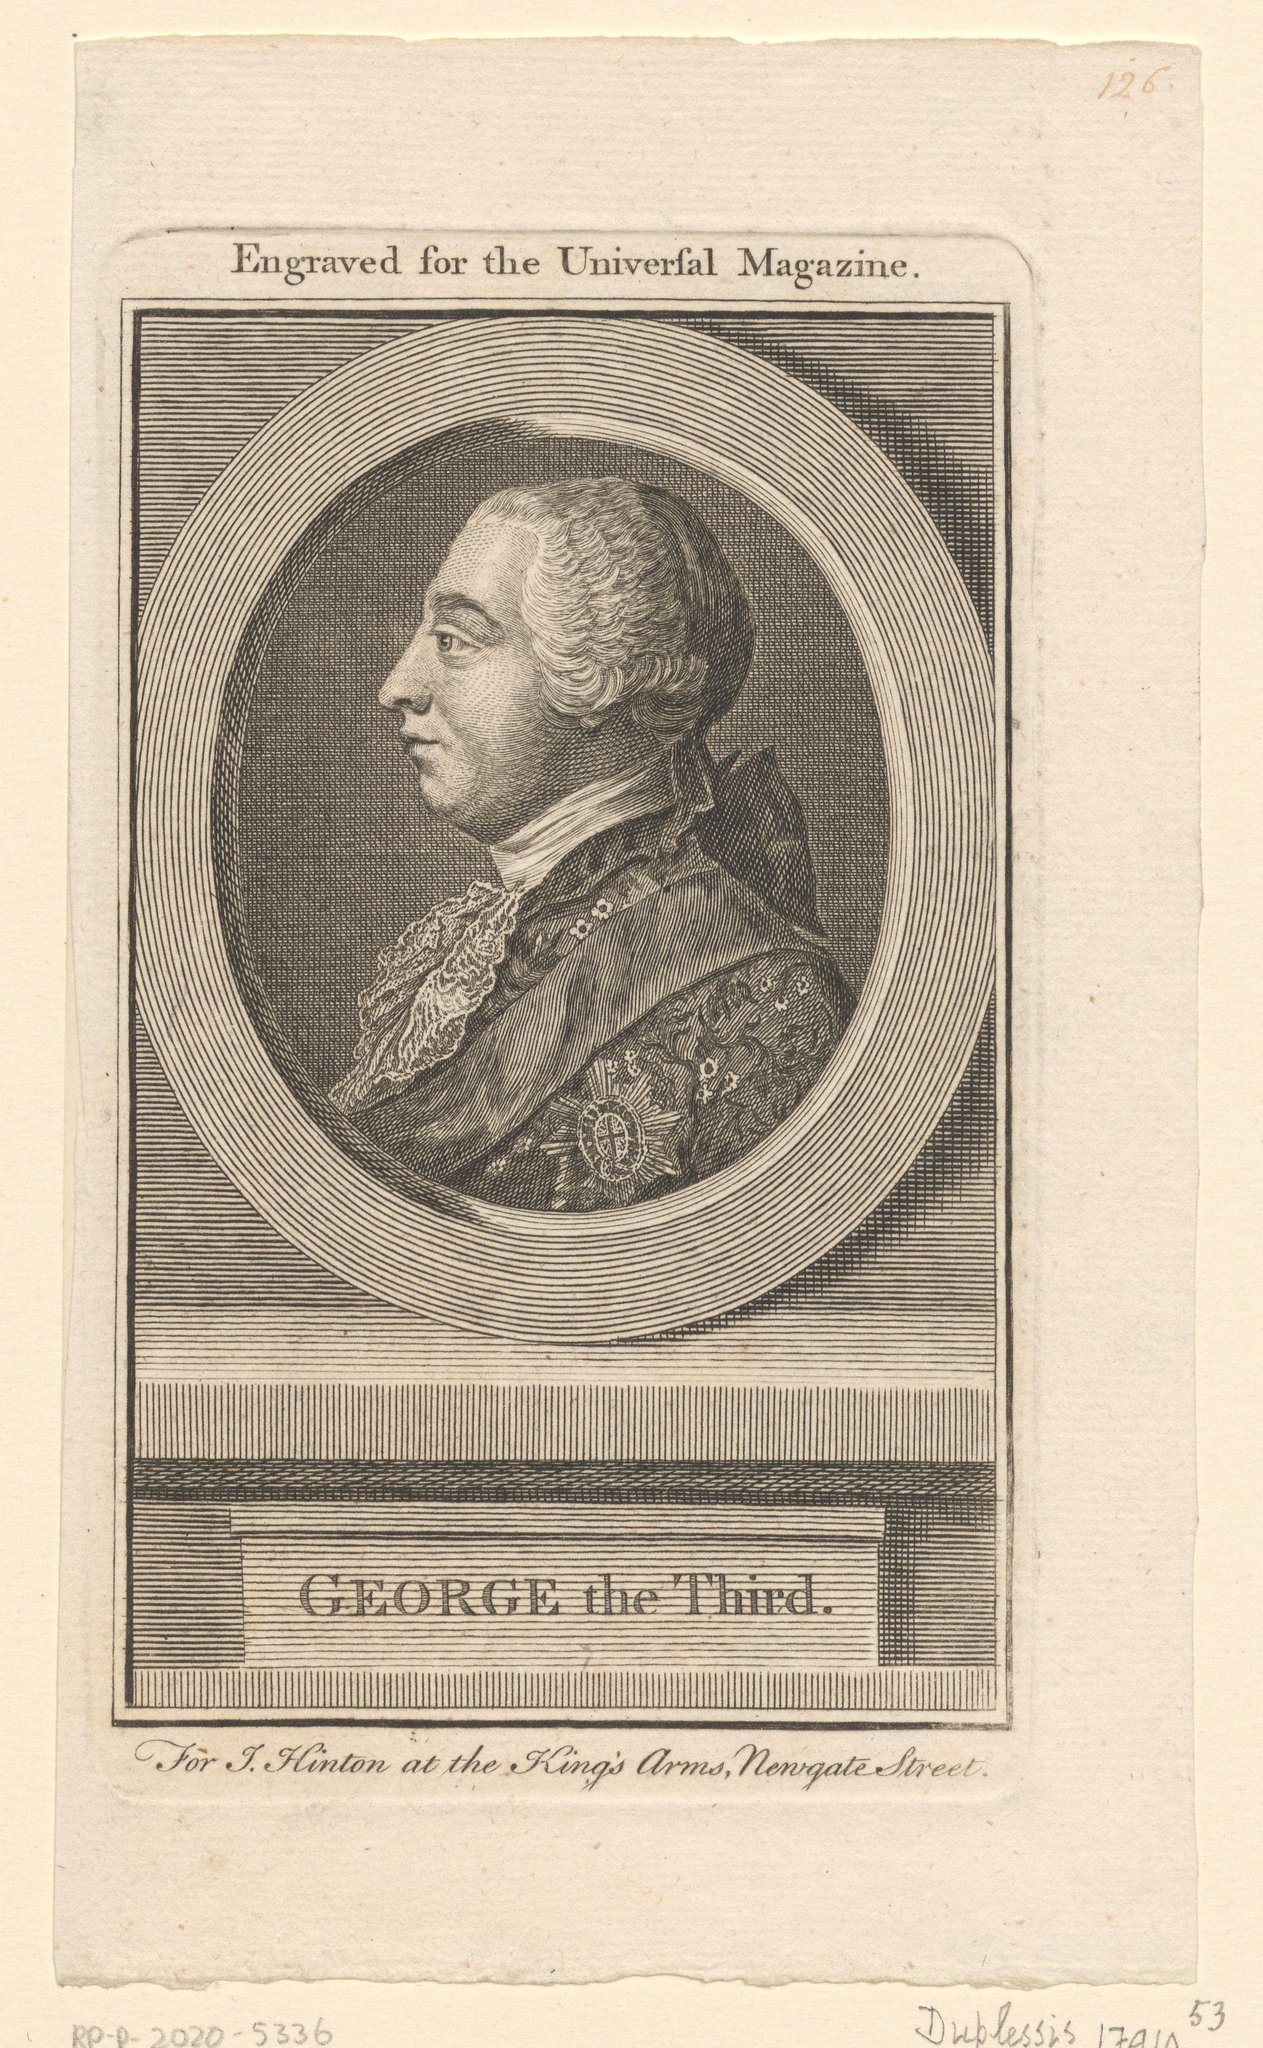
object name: print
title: Portret van George III, koning van het Verenigd Koninkrijk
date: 1747-1781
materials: paper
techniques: engraving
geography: london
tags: london, george iii (koning van het verenigd koninkrijk), historical persons, king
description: Prent uit: The Universal Magazine of Knowledge and Pleasure, 1747-1781.